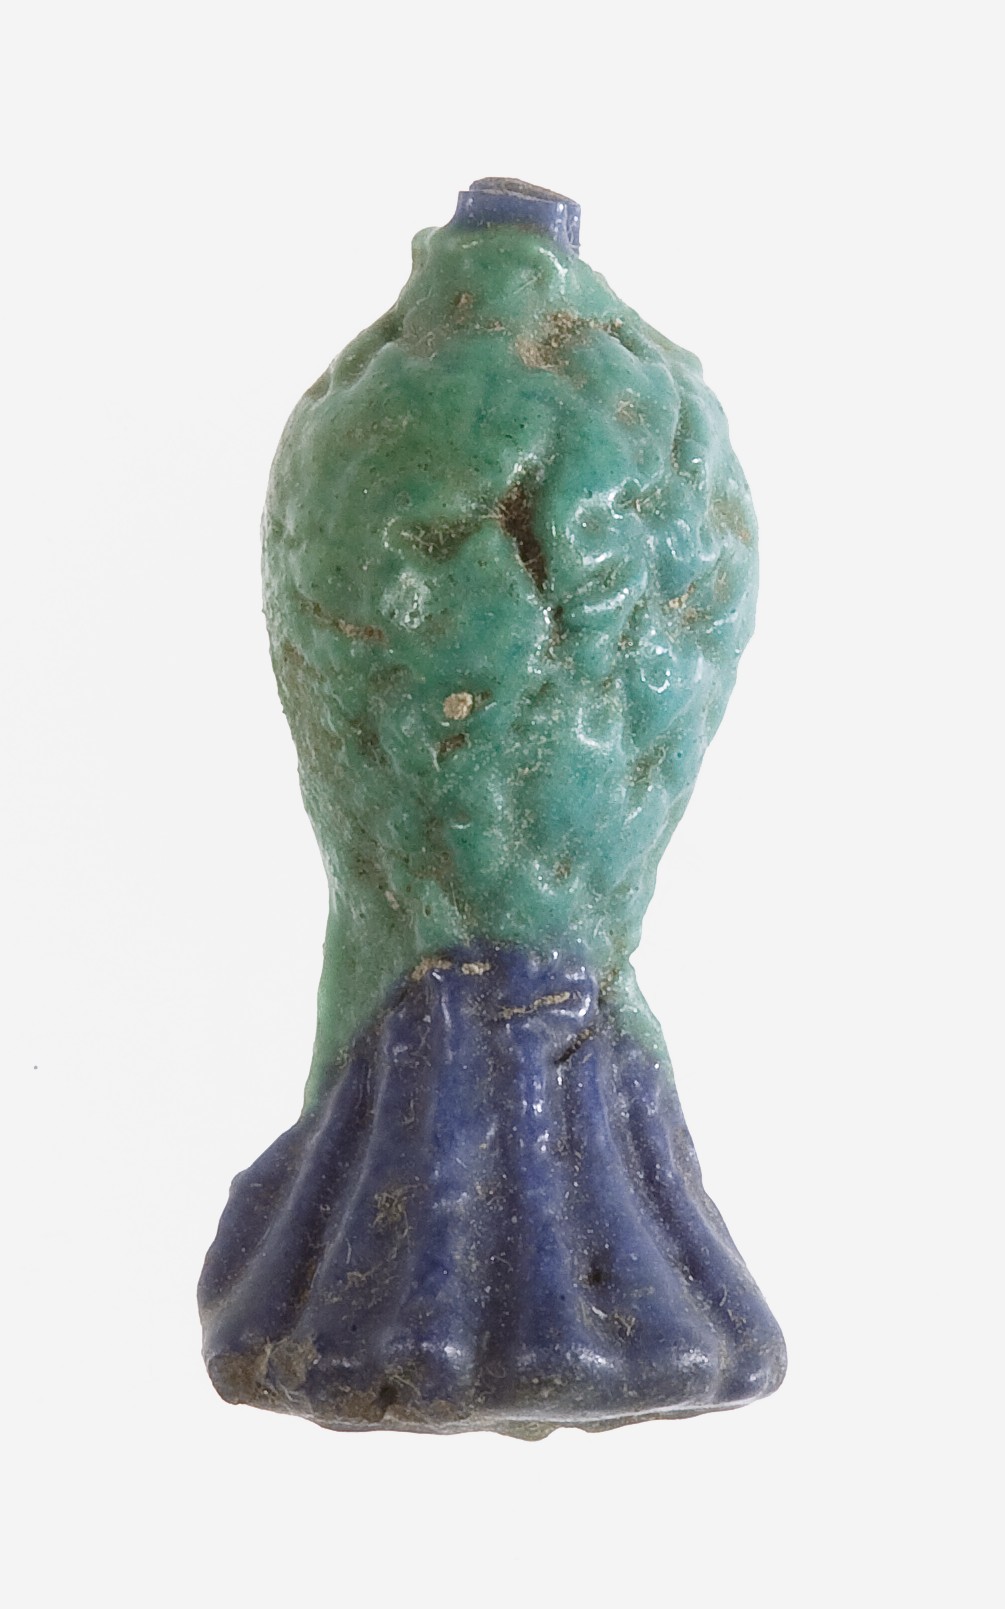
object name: pendant, cornflower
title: Cornflower Pendant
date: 1390-1352 BCE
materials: faience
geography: egypt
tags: flowers